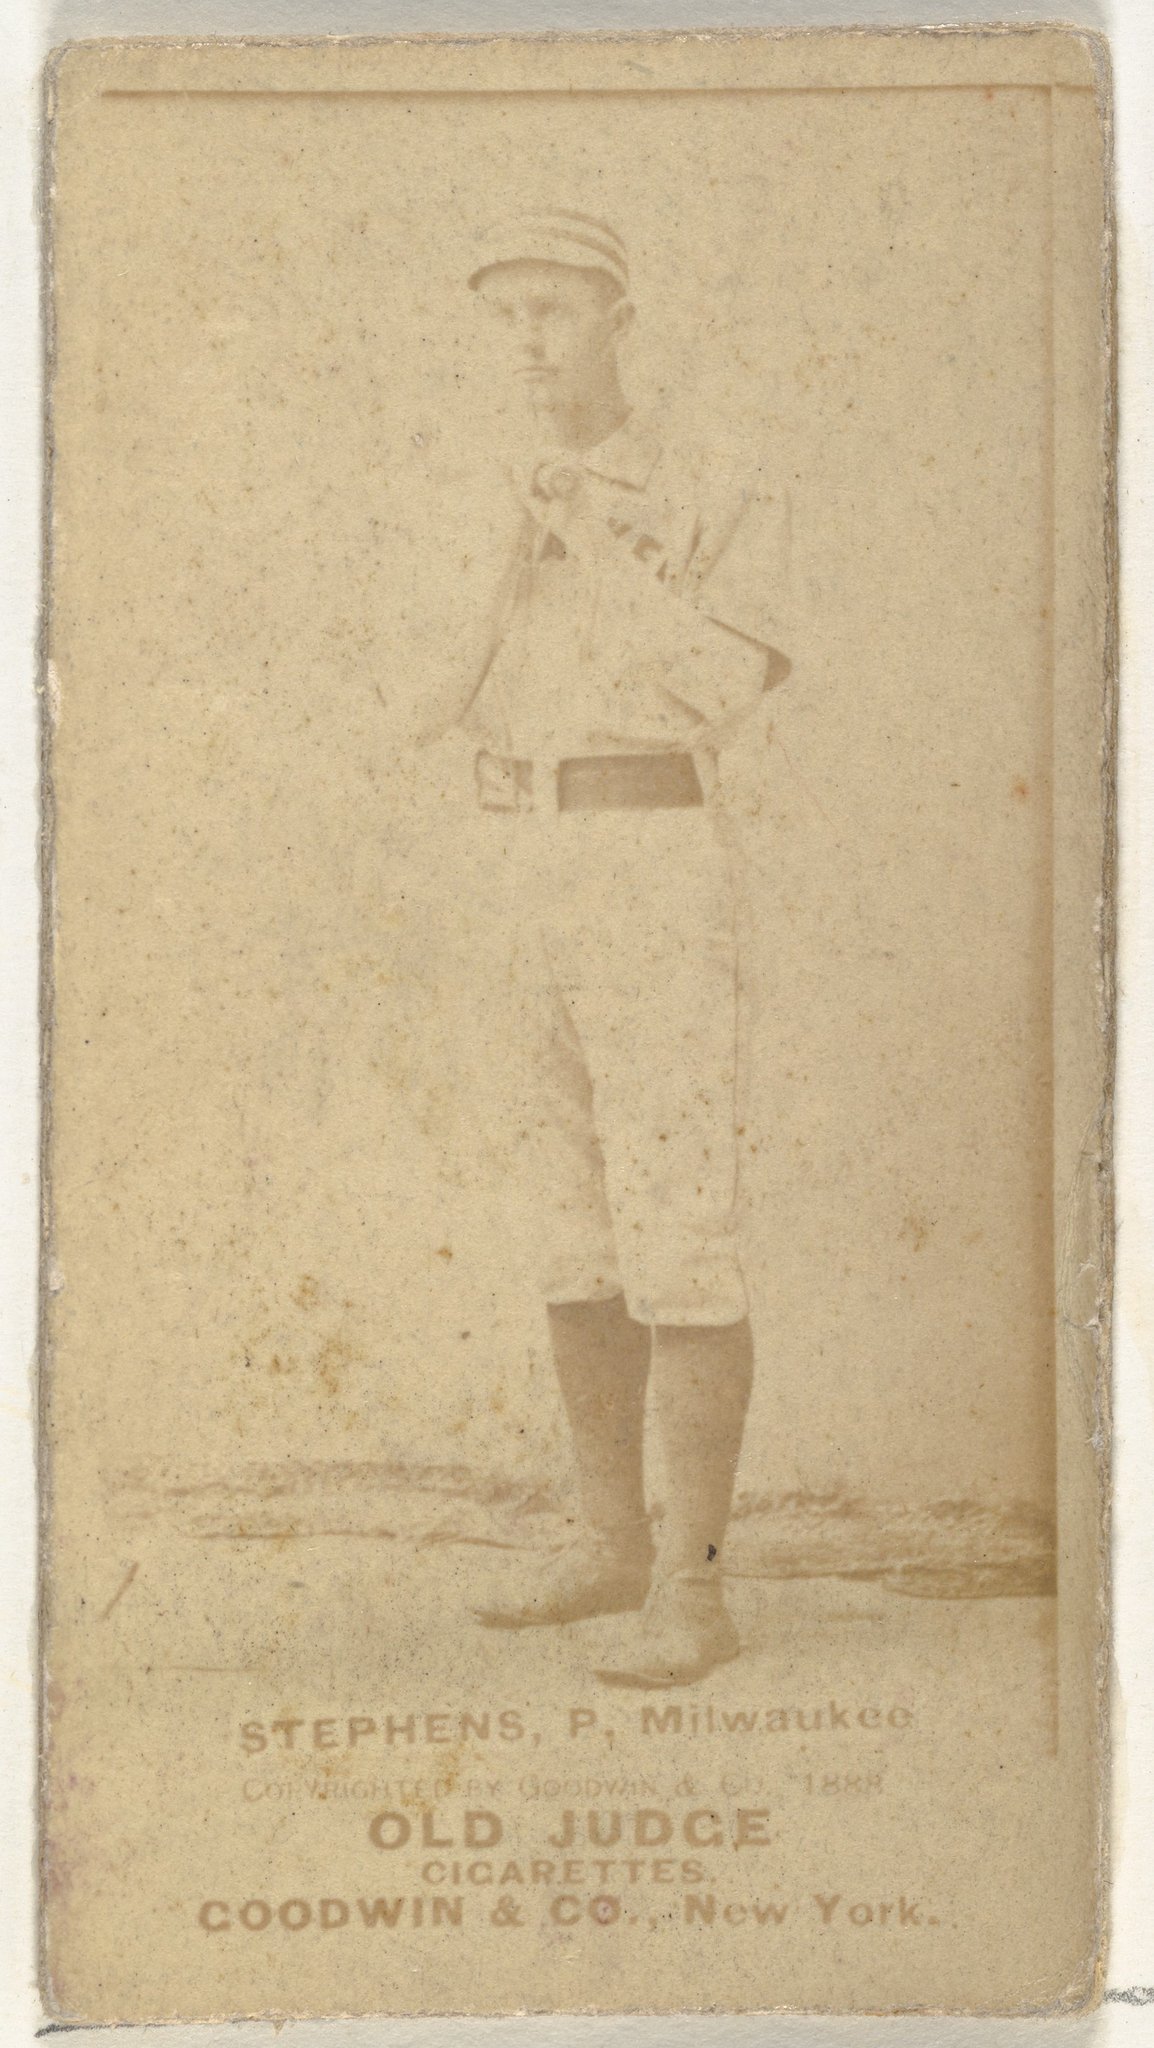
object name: baseball card, photograph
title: George Benjamin "Ben" Stephens, Pitcher, Milwaukee, from the Old Judge series (N172) for Old Judge Cigarettes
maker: goodwin & company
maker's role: publisher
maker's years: 1850-1950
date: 1888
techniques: albumen silver print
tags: men,portraits,baseball,athletes